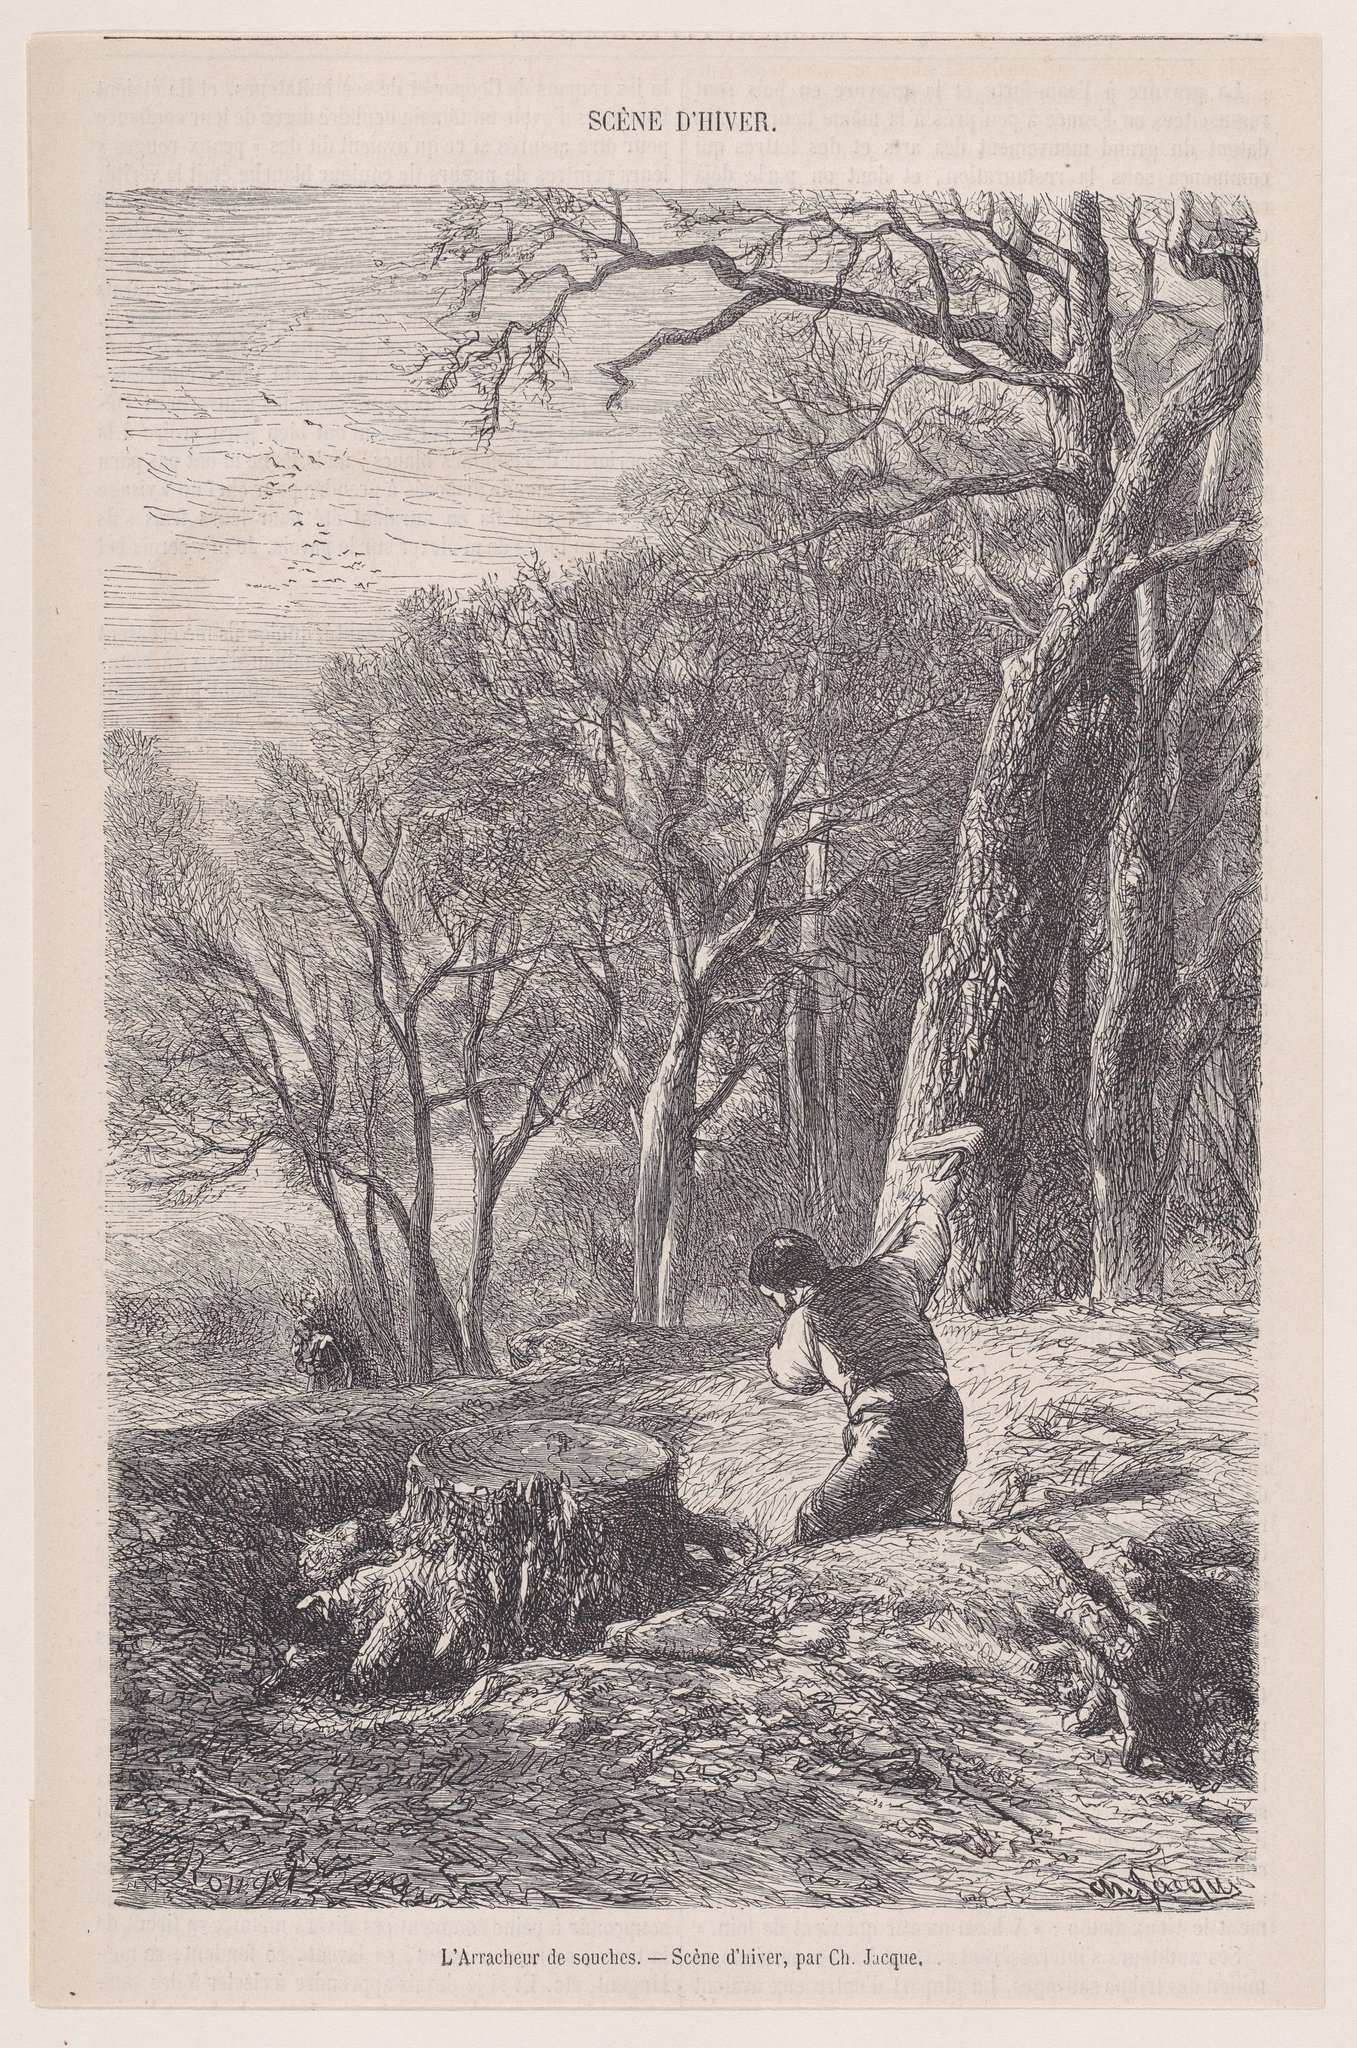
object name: print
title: Winter Scene: Removing Stumps, from "Le Magasin Pittoresque"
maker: charles émile jacque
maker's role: artist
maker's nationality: french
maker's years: 1813-1894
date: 1852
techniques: engraving